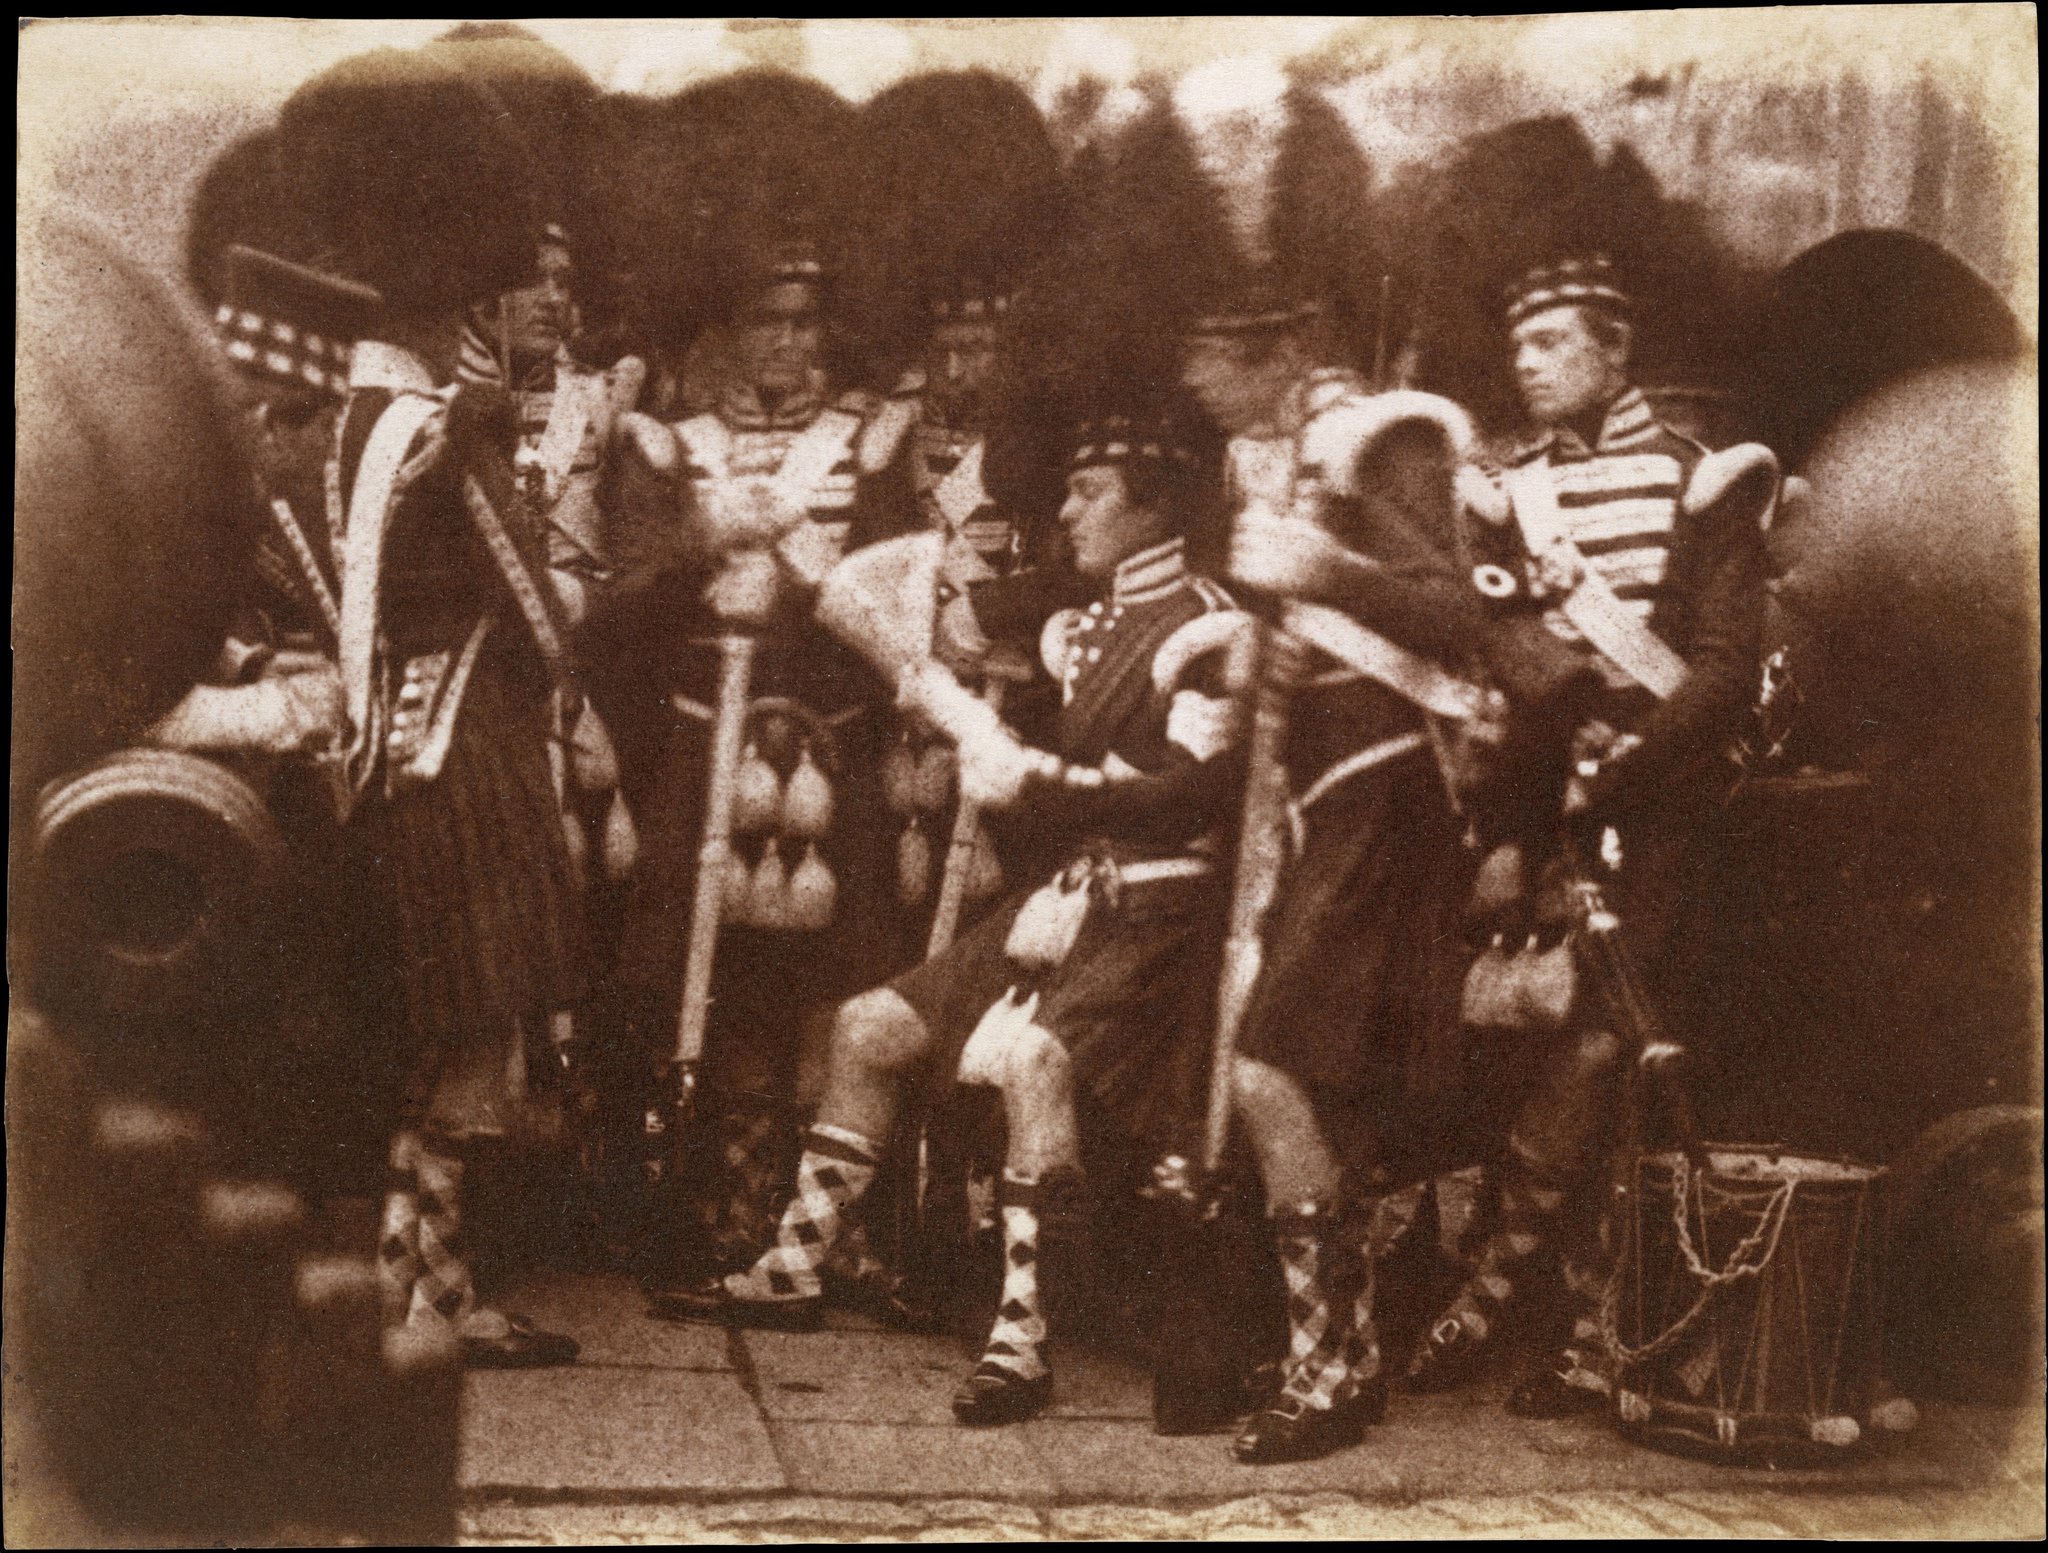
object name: photograph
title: [Officer of the 92nd Gordon Highlanders Reading to the Troops, Edinburgh Castle]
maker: hill and adamson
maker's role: photography studio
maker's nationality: british, scottish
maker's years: 1843-1848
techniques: paper negative, salted paper print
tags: soldiers,cannons,men